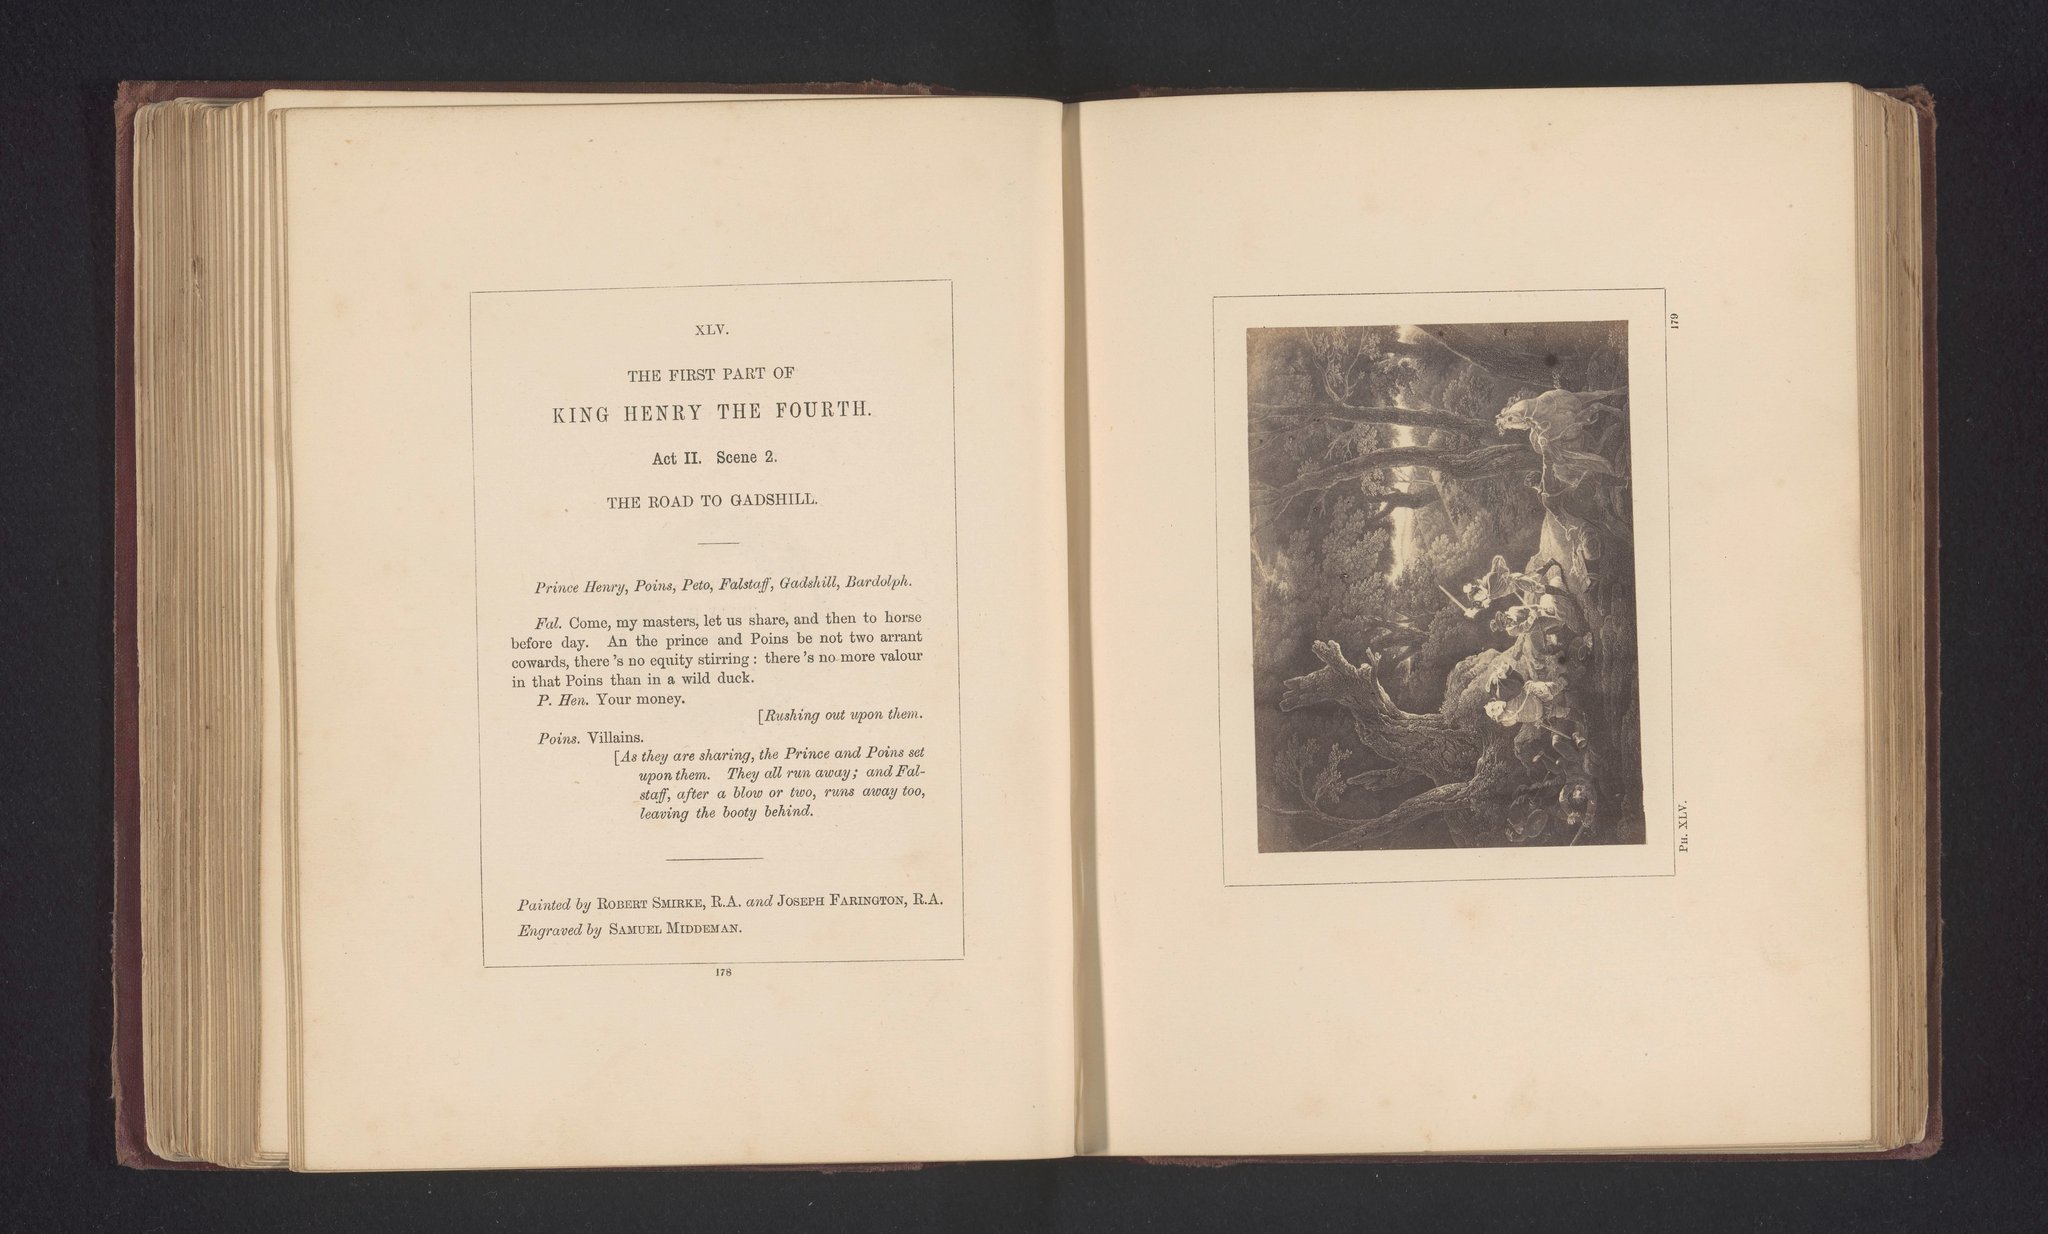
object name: reproduction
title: Fotoreproductie van een prent naar een schilderij door Robert Smirke en Joseph Farington, voorstellend een scene uit Hendrik IV door William Shakespeare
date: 1854-1867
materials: photographic support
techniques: albumen print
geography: london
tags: specific works of literature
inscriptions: number: ‘Ph. XLV. 179’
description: Te zien is akte II, scene 2 met prins Hendrik, Sir John Falstaff, Edward Poins en anderen op weg naar Gadshill.